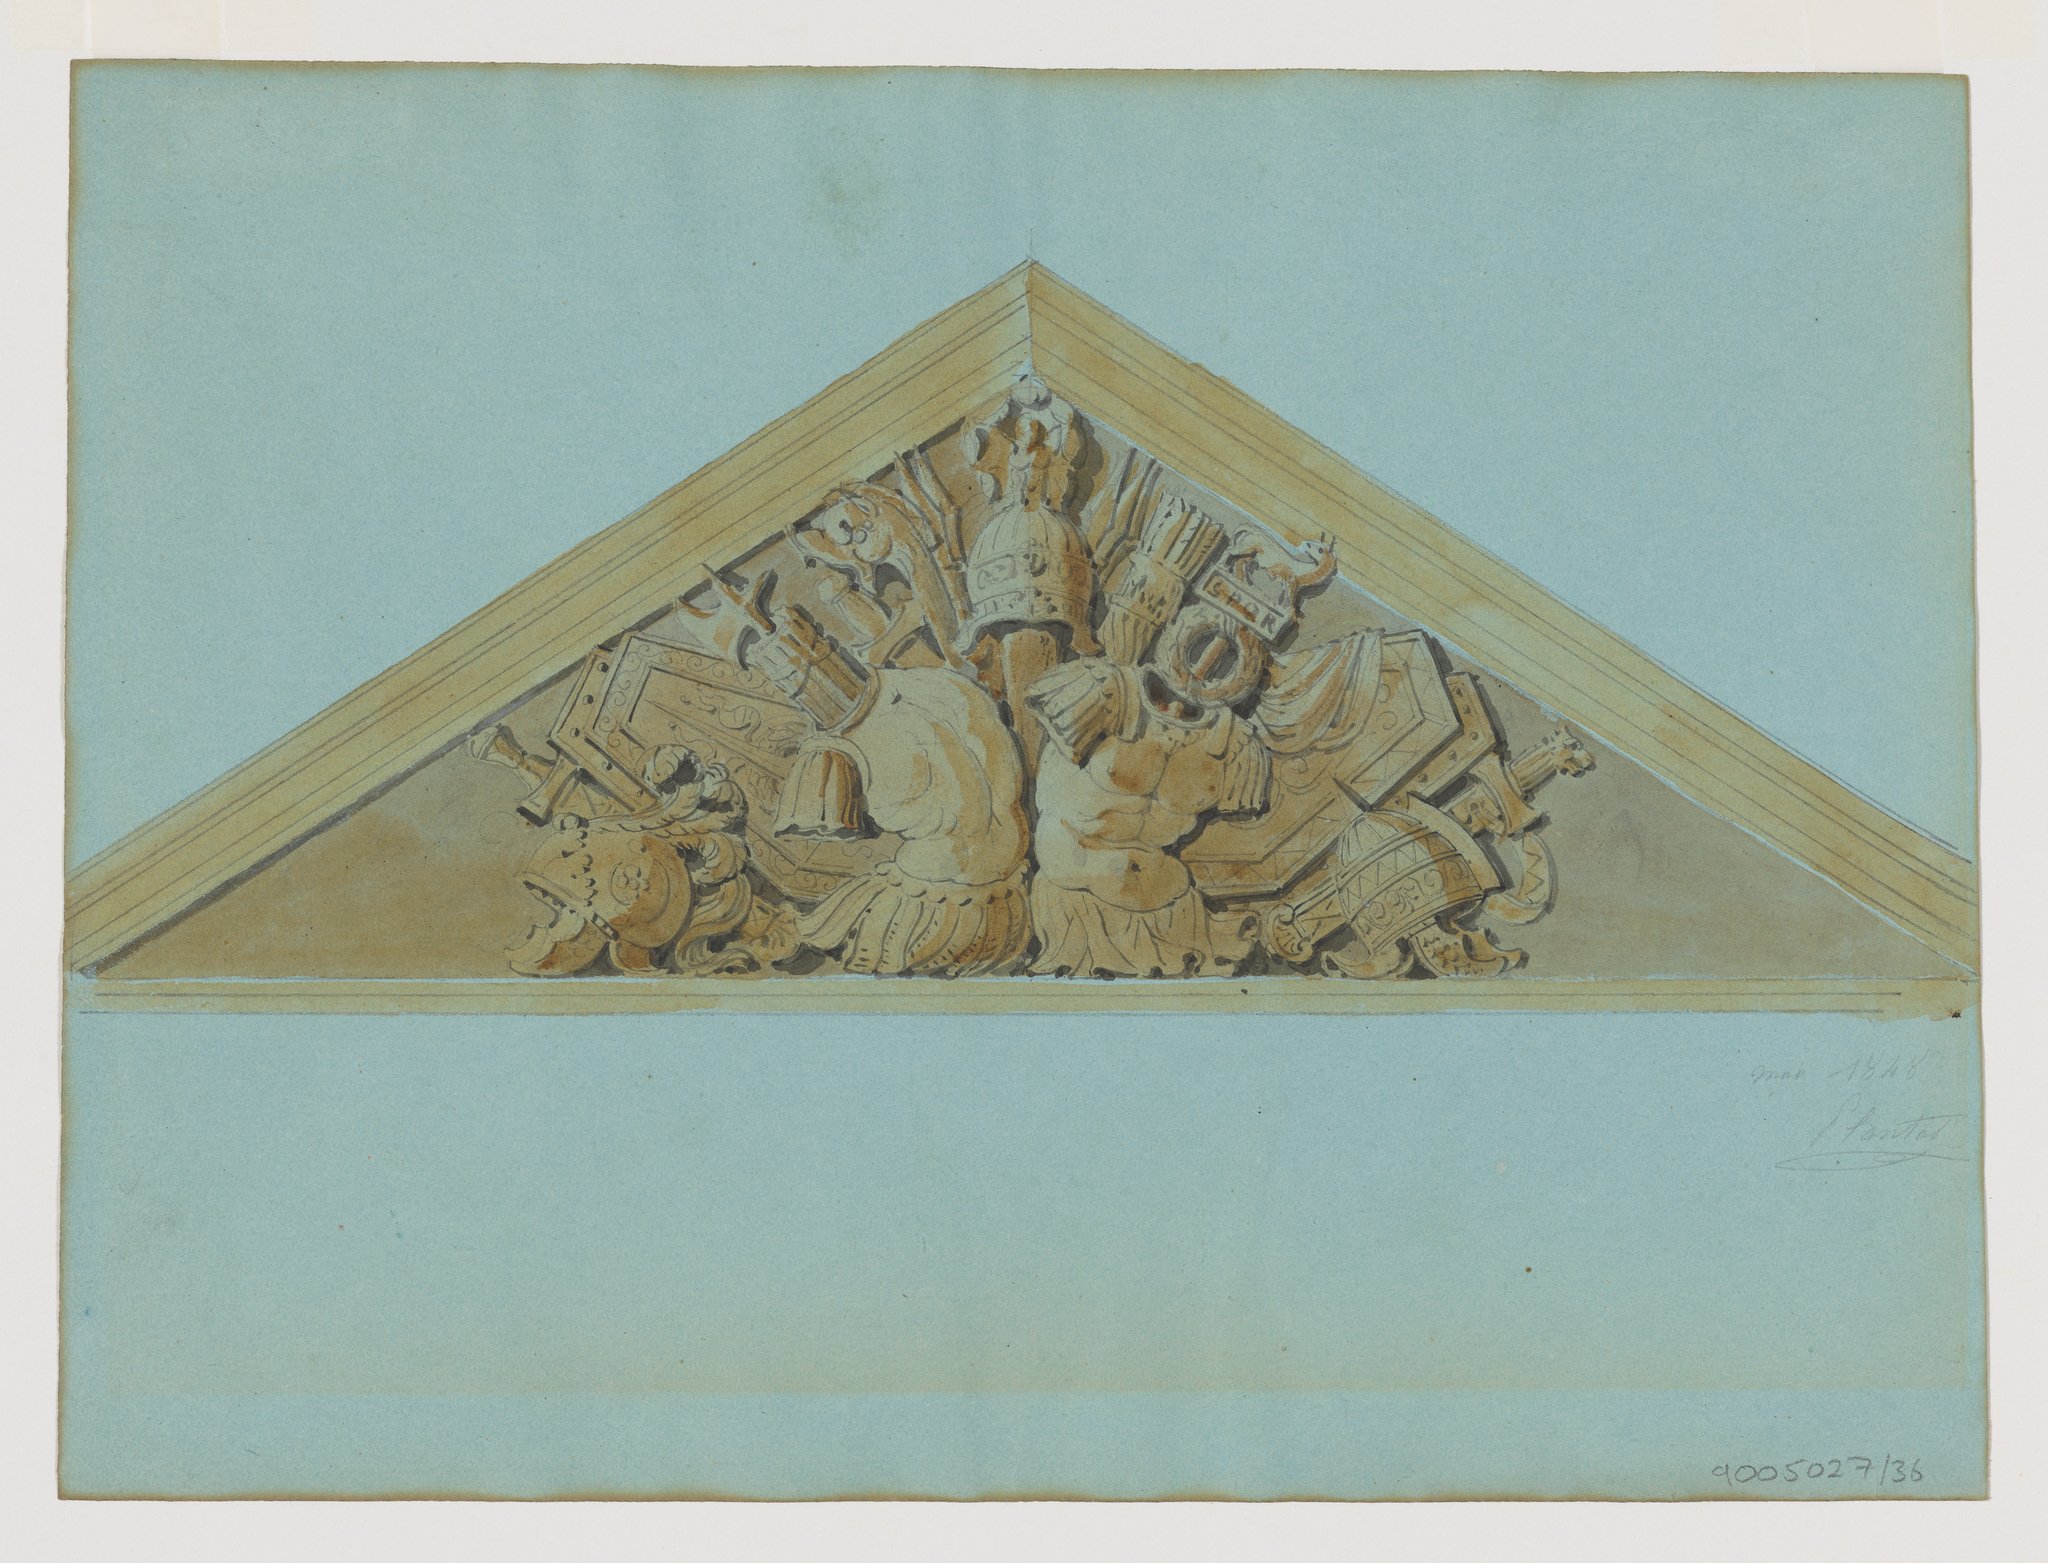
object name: drawing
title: Design for a Pediment with an Armorial Trophy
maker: jean-baptiste louis plantar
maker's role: artist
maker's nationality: french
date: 1834-1866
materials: graphite, ink, watercolor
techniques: pen